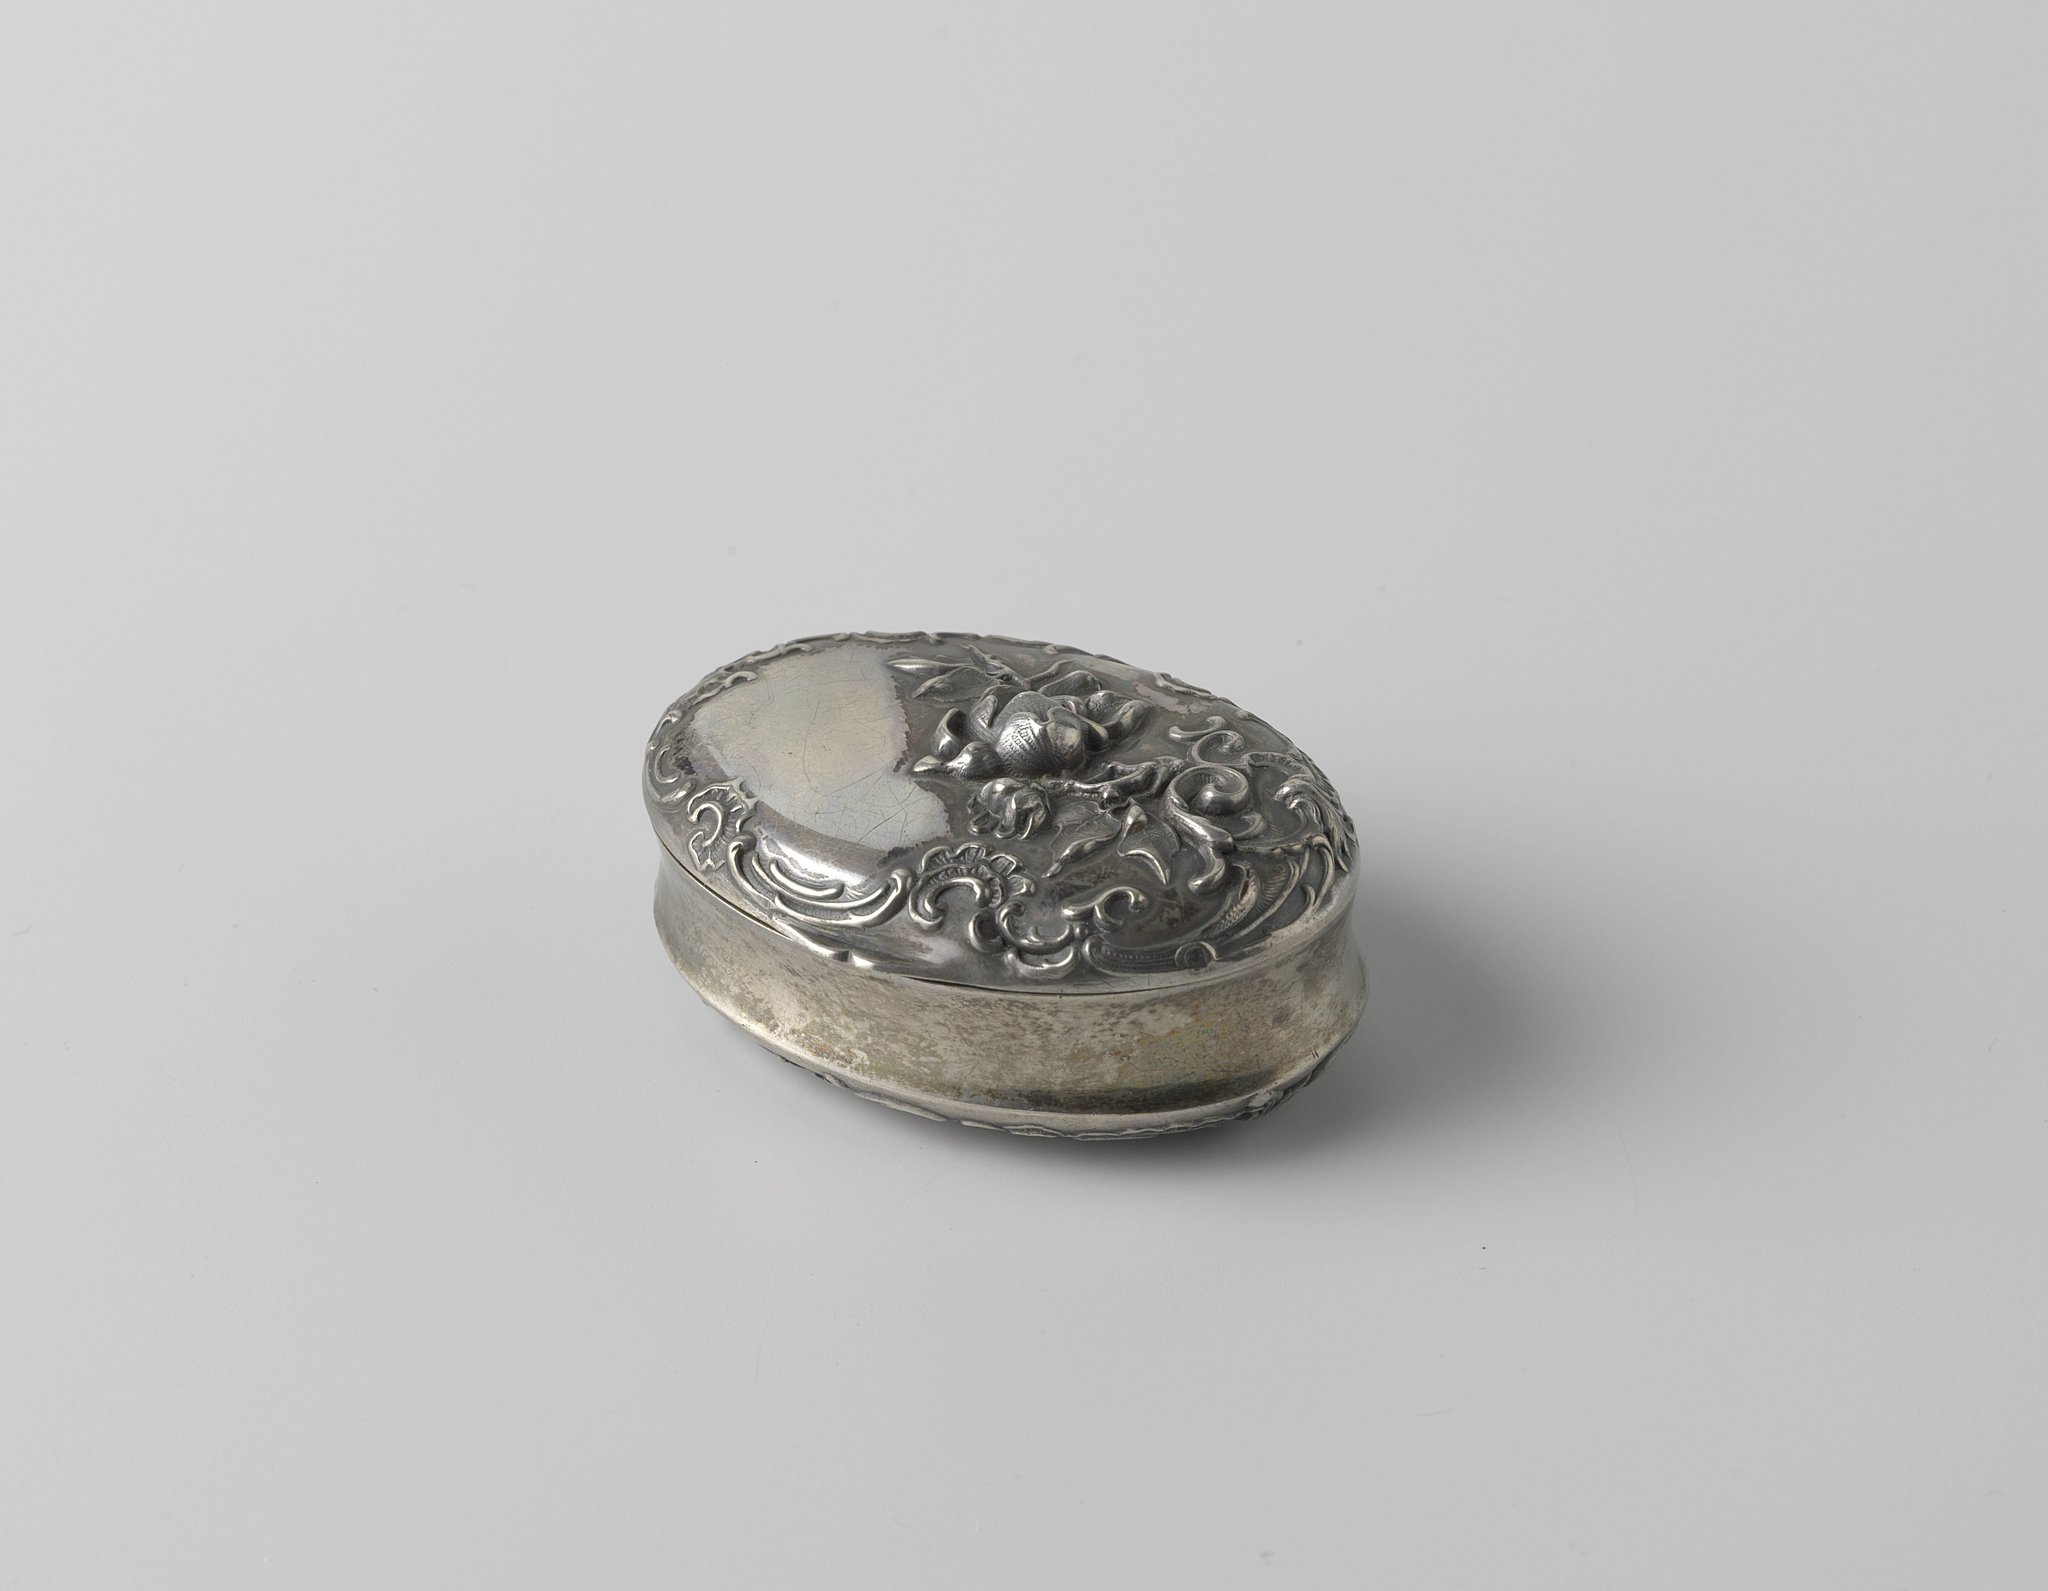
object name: box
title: Loddereindoos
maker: Anonymous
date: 1800-1900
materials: silver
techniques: gilding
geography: netherlands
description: Ovale loddereindoos van zilver in Lodewijk XV-stijl. Onder en bovenzijde met bloemen en rocailles versierd. Van binnen verguld.